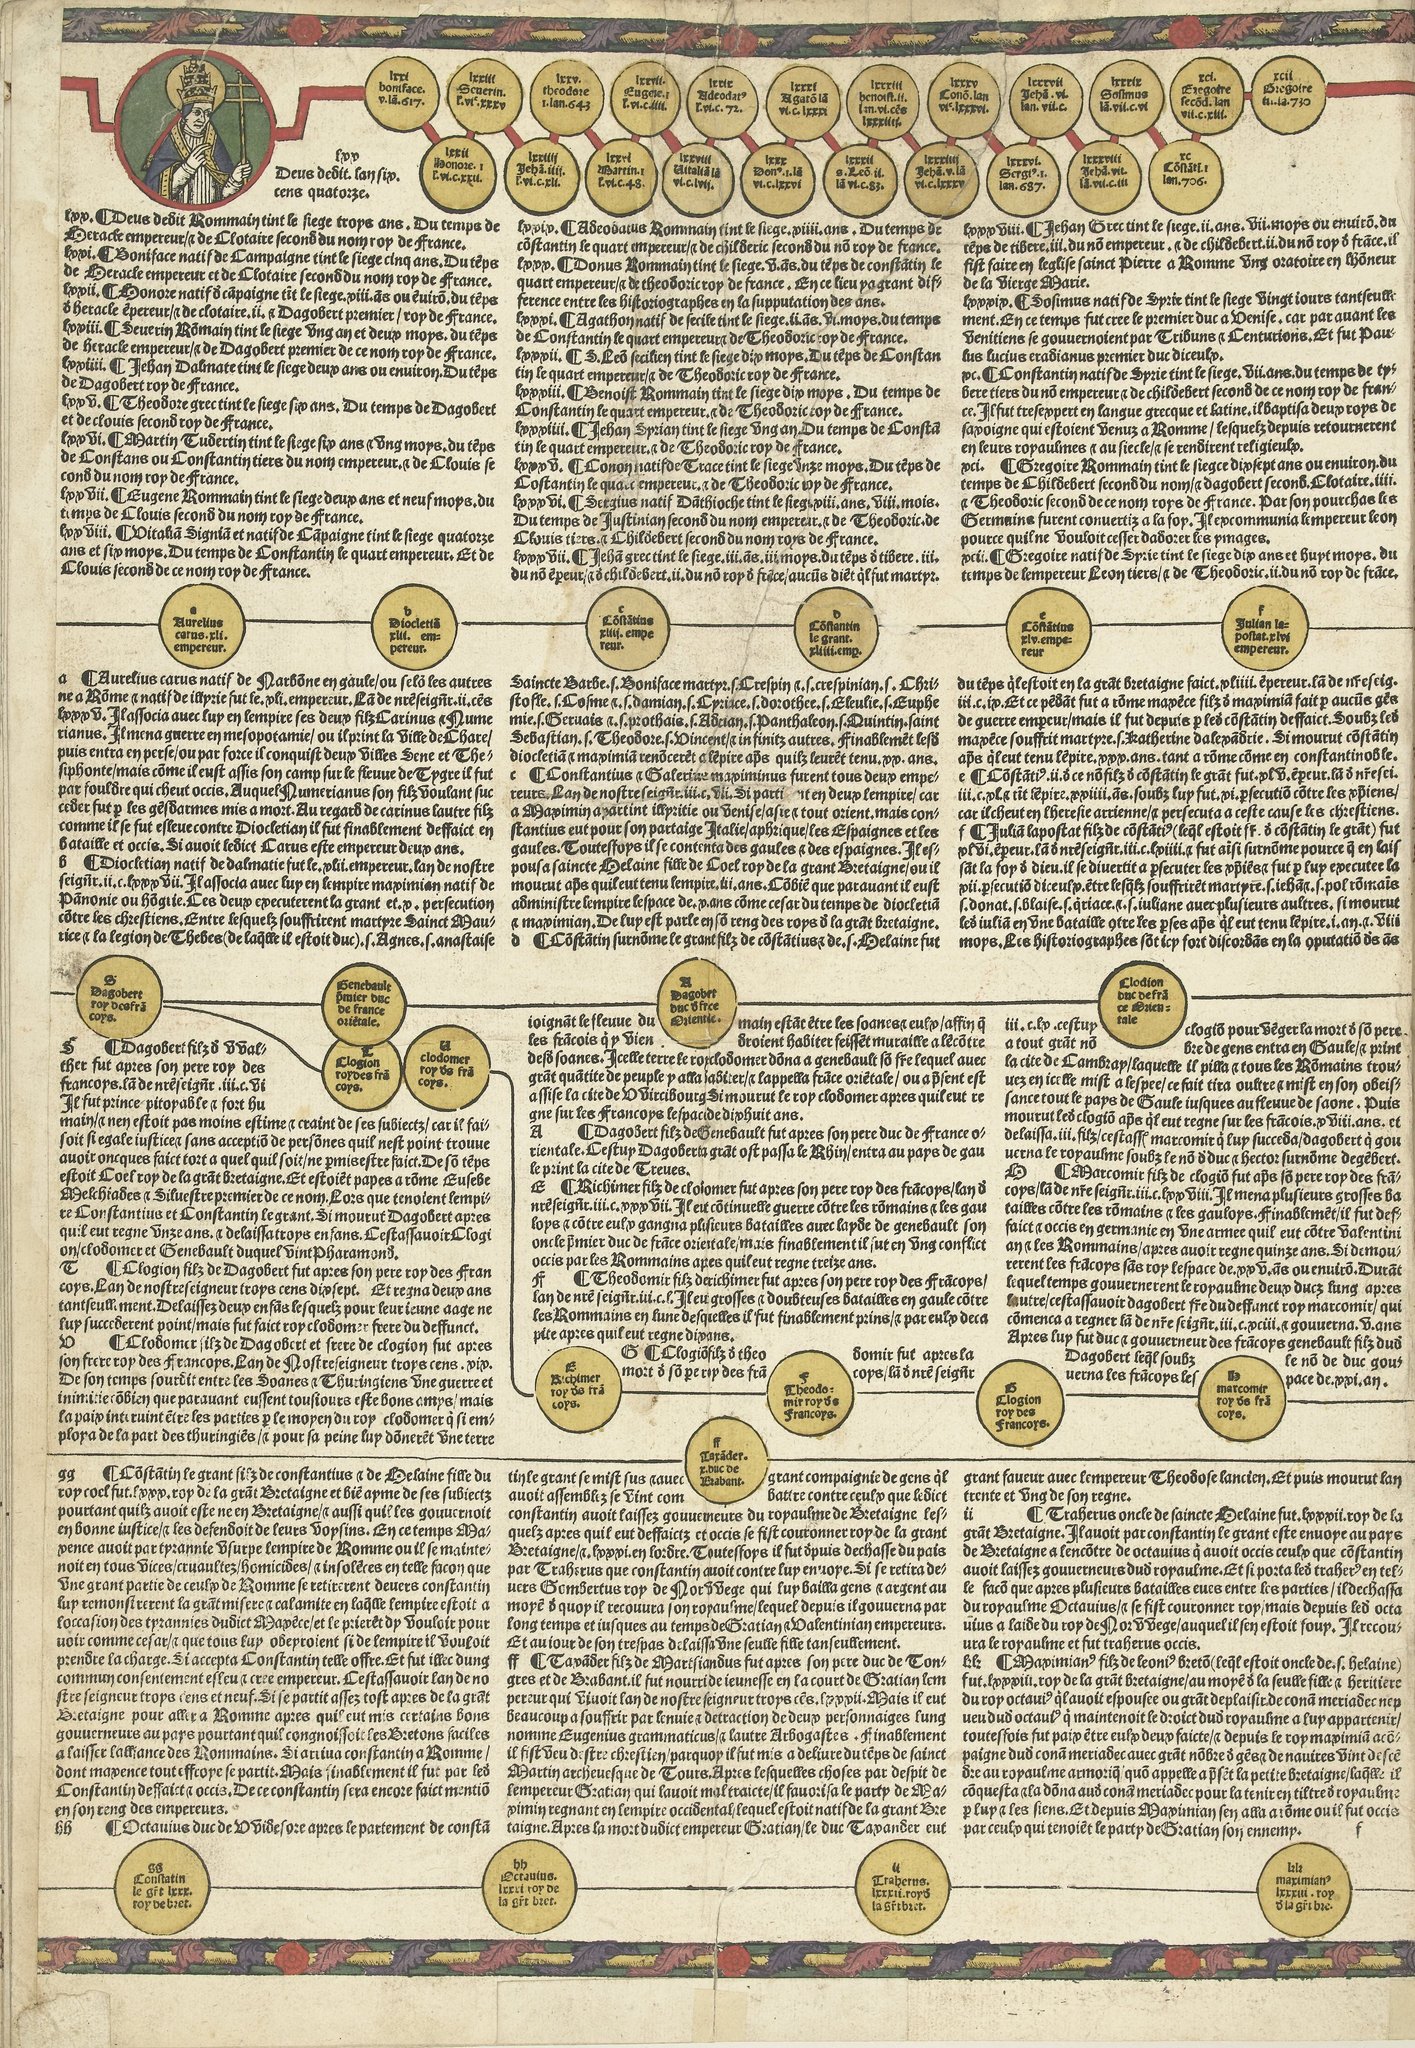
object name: album leaf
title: Cronica Cronicarum (...), blad 11 verso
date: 1521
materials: paper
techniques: letterpress printing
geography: paris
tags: pope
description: Blad 11 verso van een wereldkroniek. Tekst in boekdruk in het Frans in drie kolommen. Linksboven een ronde voorstelling van paus Adeodatus I (Deusdedit). De ronde voorstelling is verbonden met andere cirkels die gevuld zijn met namen: deze vormen samen een schematische weergave van genealogie en vorstenopvolging, die zich uitstrekt over meerdere bladzijden van de kroniek.